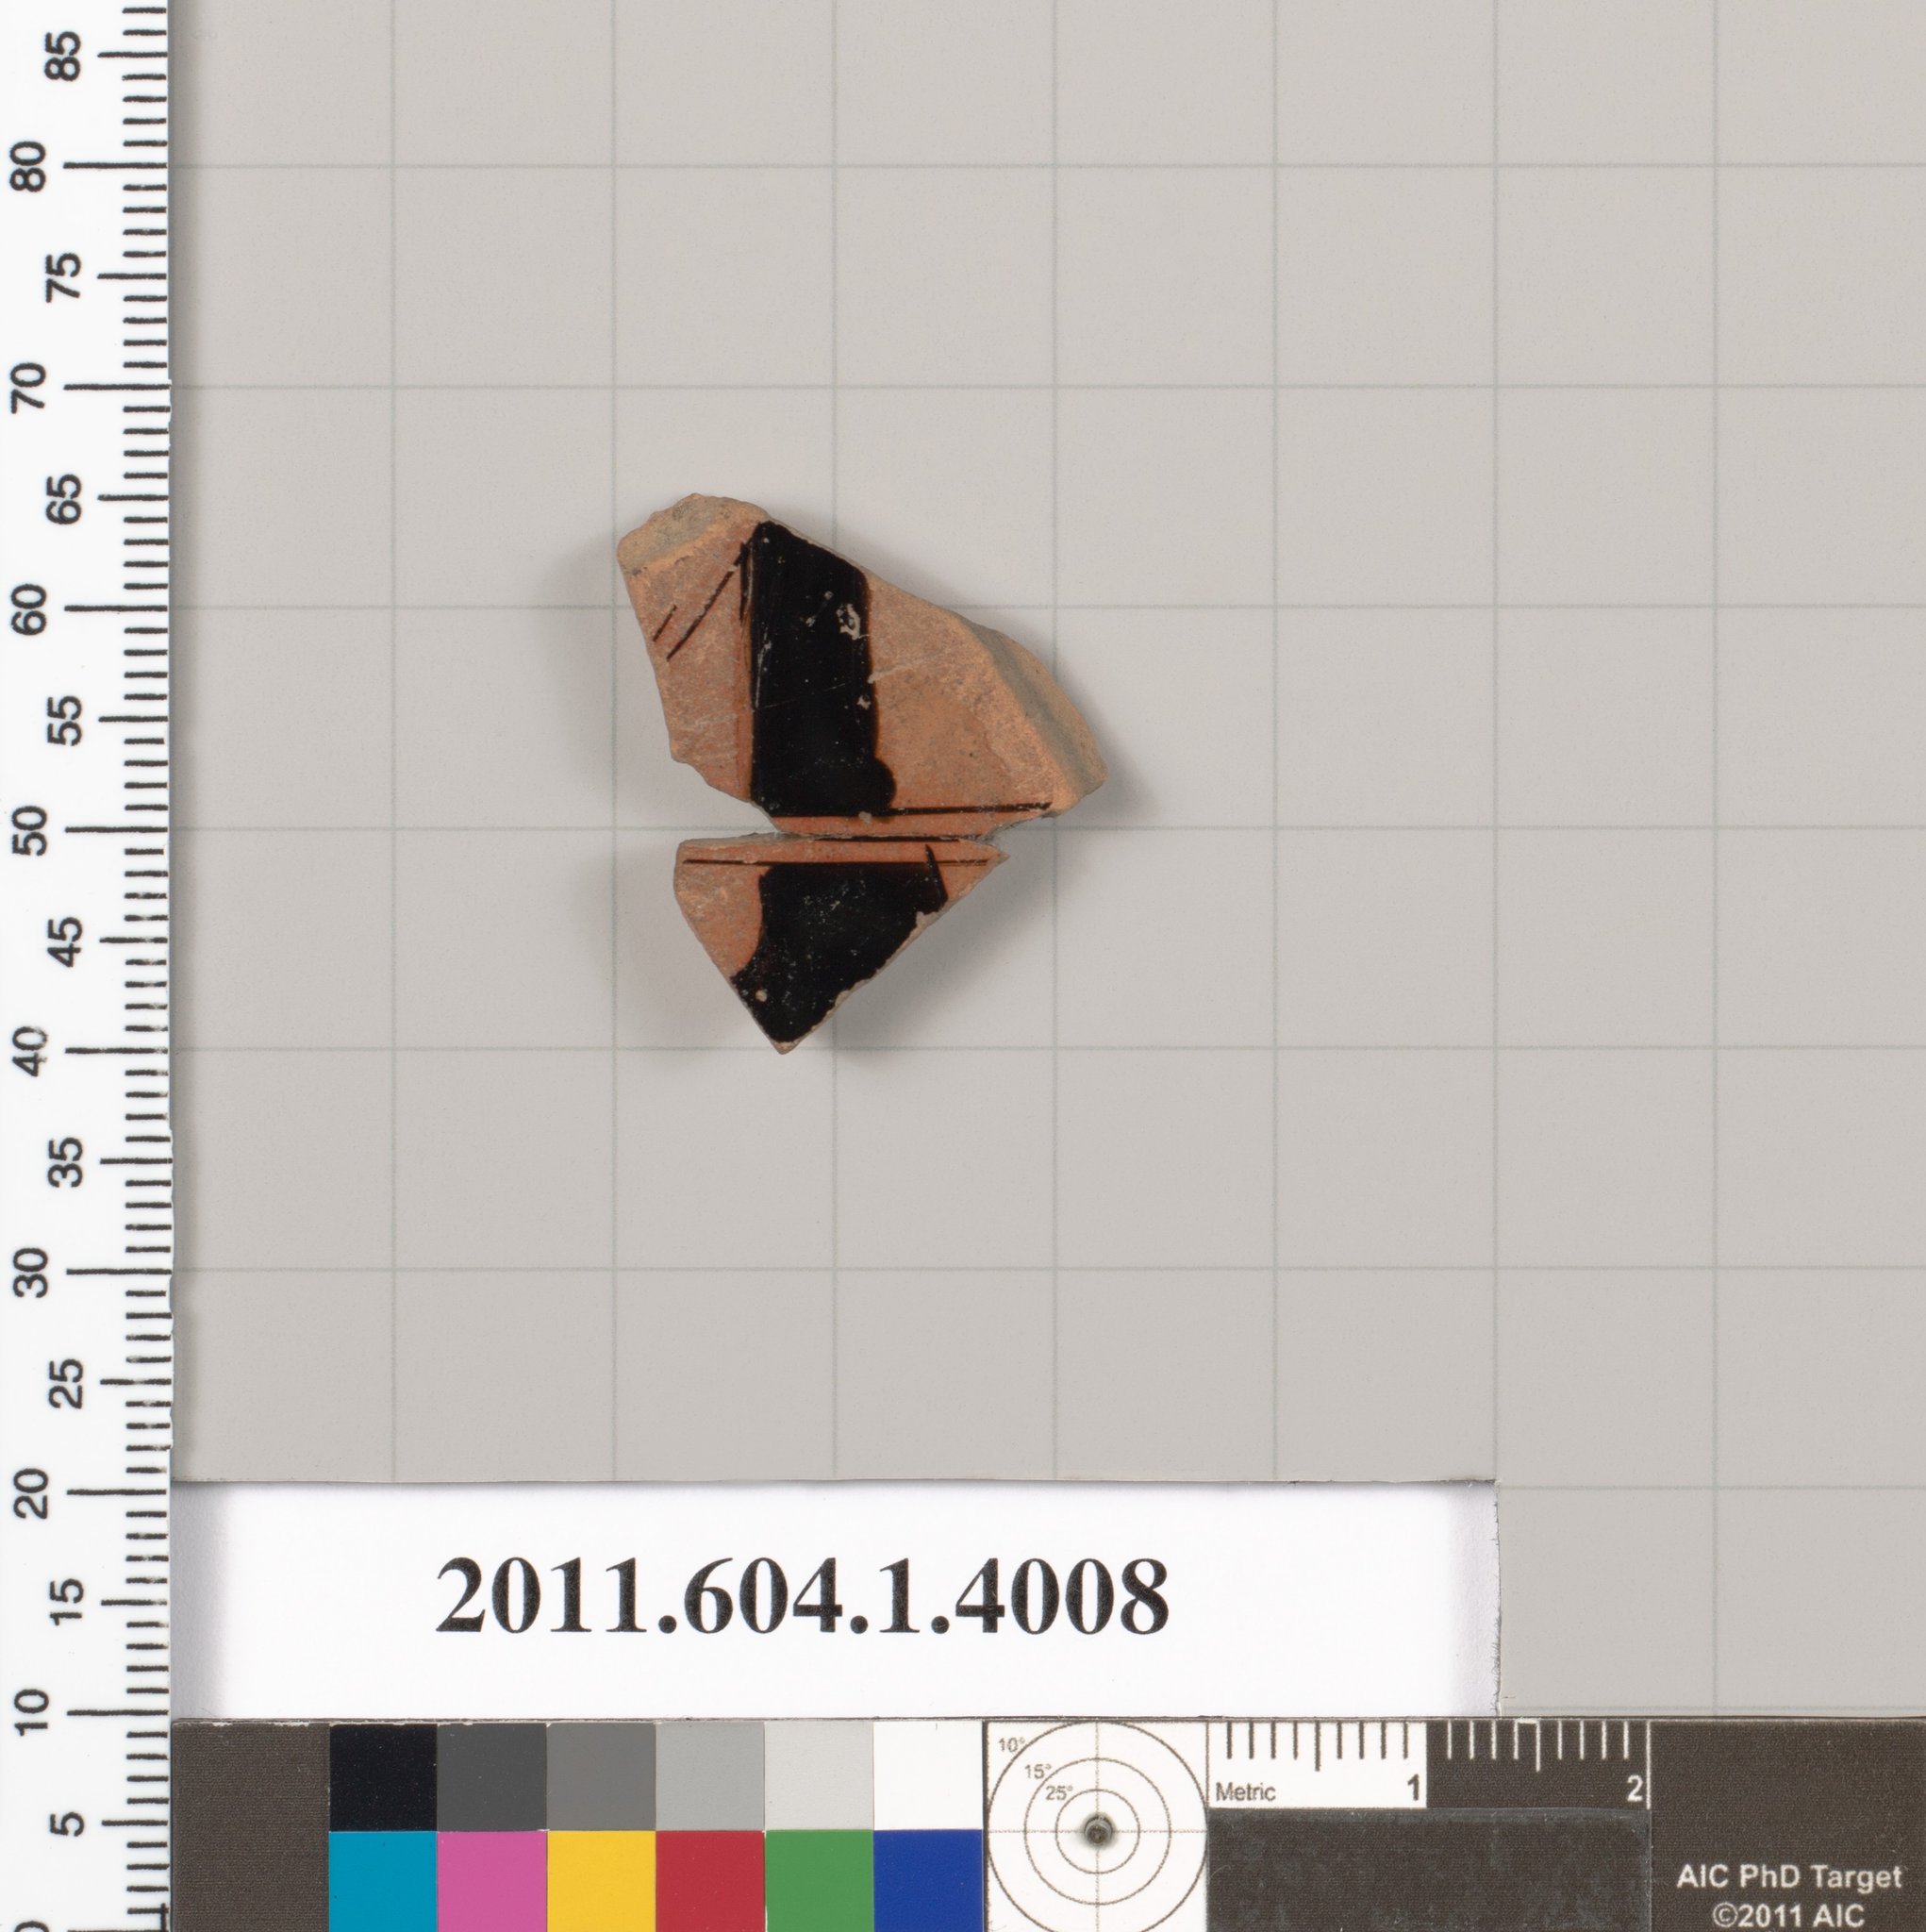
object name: kylix fragment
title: Terracotta fragment of a kylix (drinking cup)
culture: greek, attic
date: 475-451 BCE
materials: terracotta